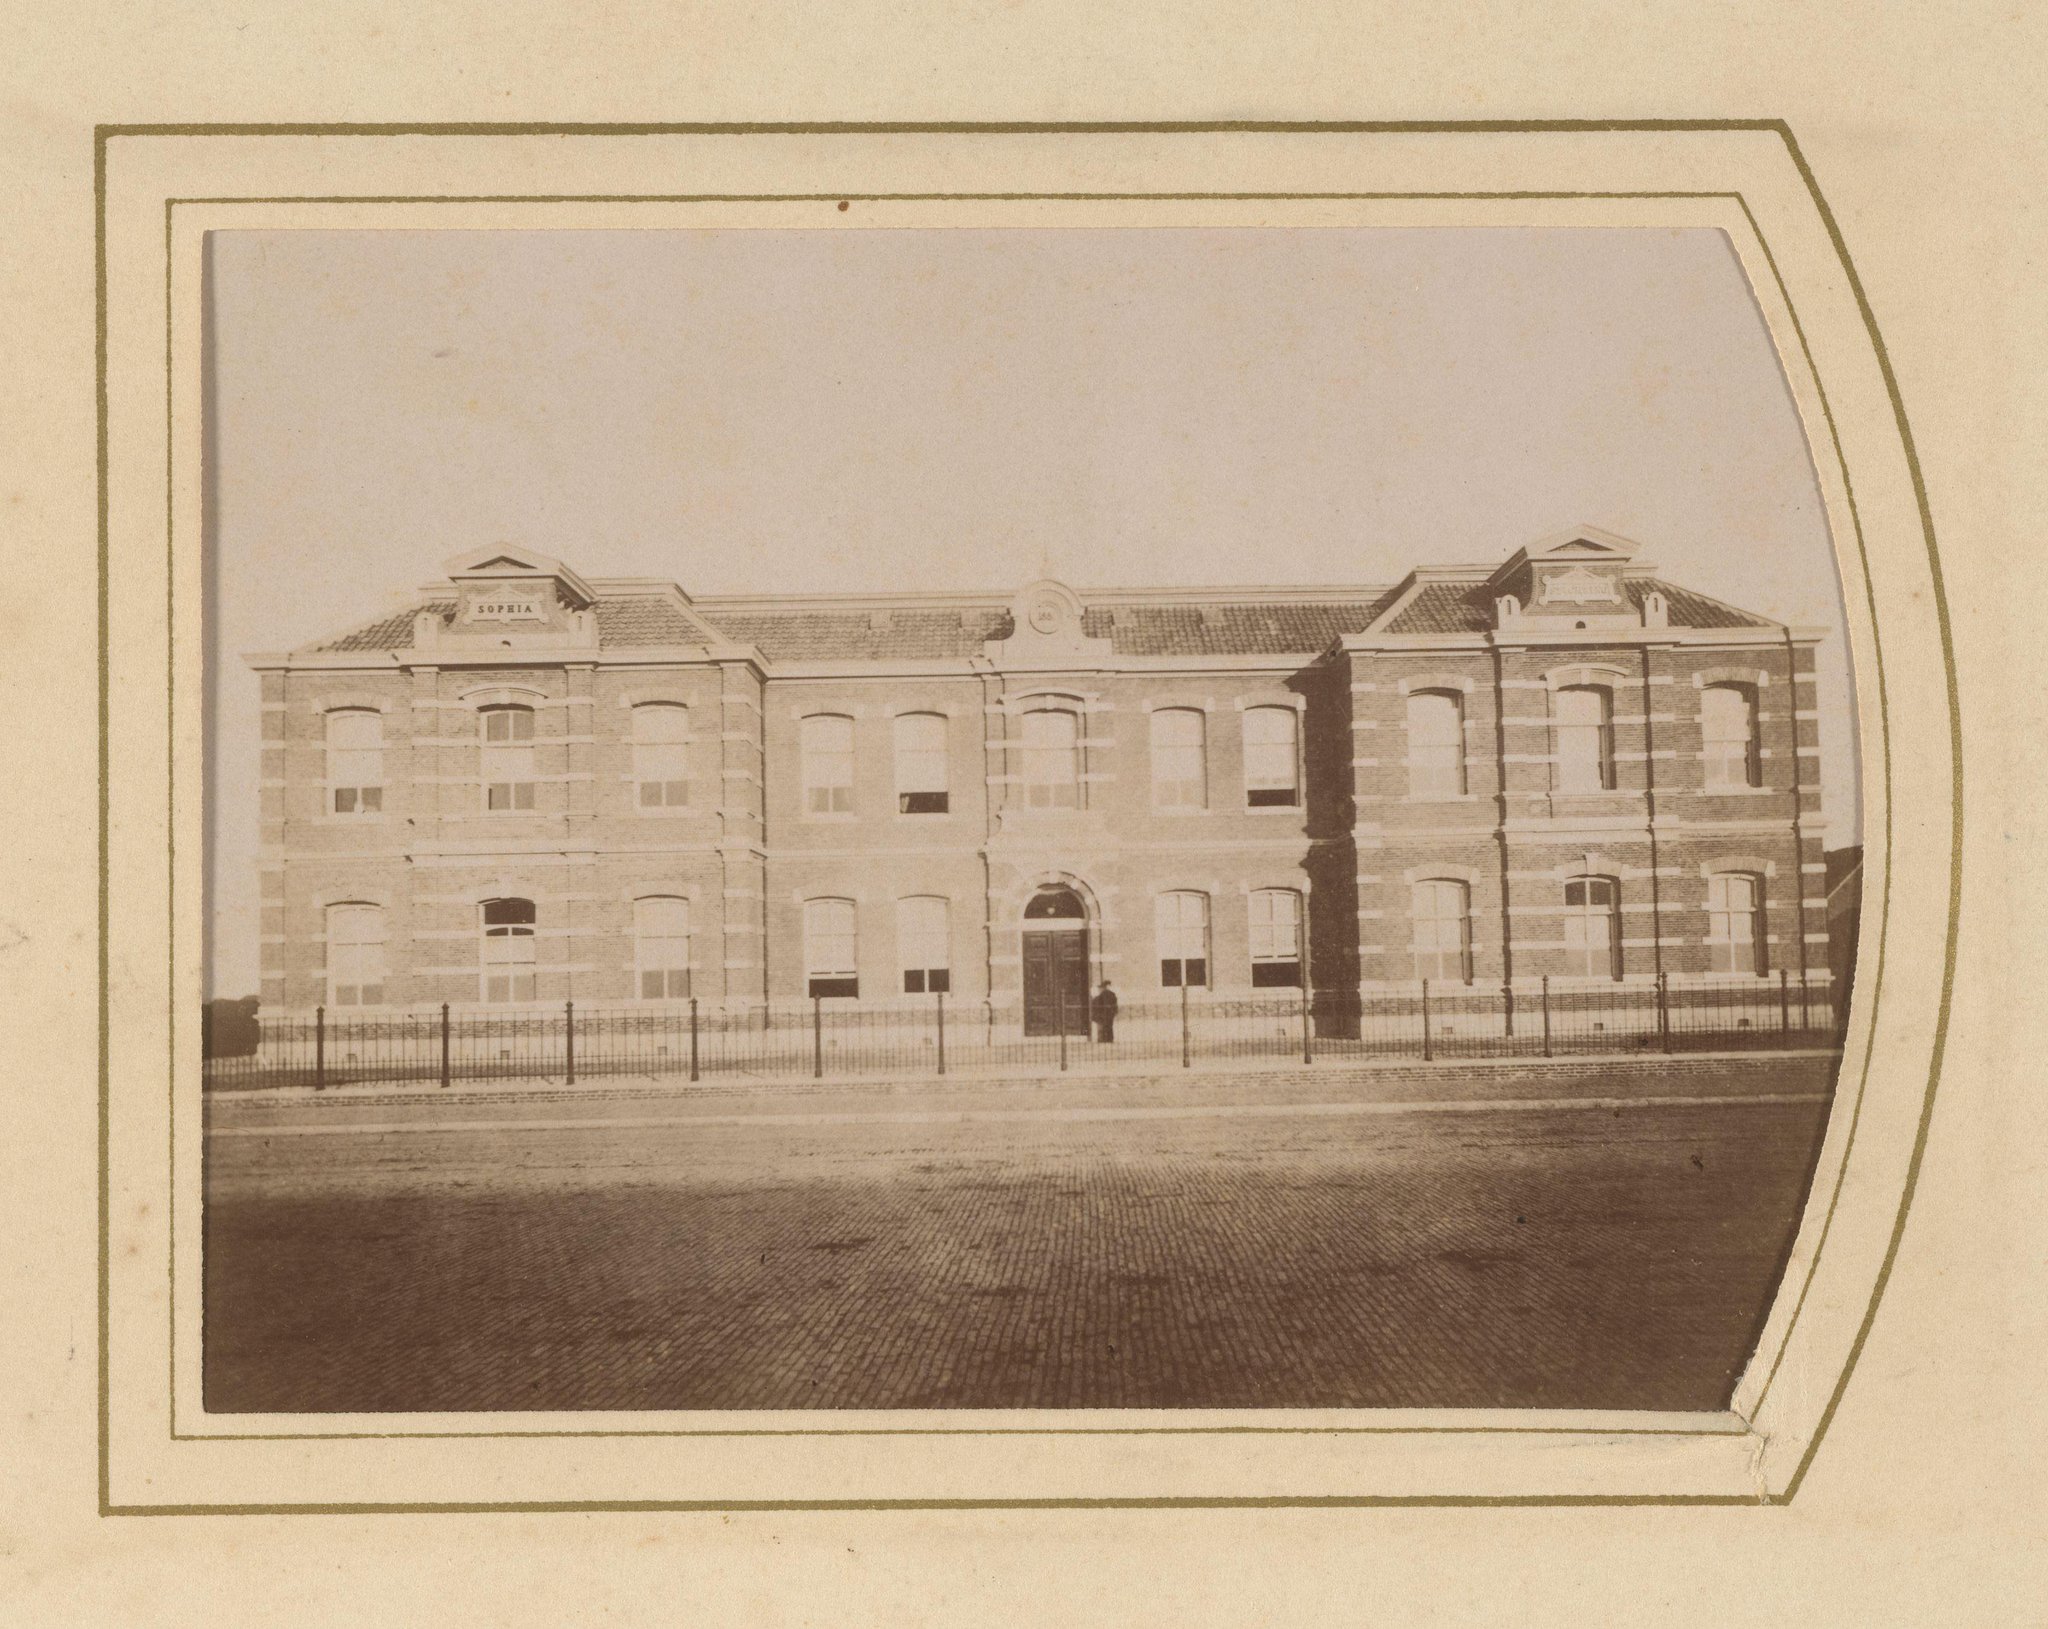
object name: photograph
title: Gezicht op het gebouw van de Sophia Stichting aan de Gevers Deynootweg in Den Haag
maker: heinrich wilhelm wollrabe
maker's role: fotograaf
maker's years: 1843-1928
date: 1877-1901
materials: cardboard, photographic support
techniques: albumen print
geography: the hague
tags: hospital, civic architecture; edifices; dwellings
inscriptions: inscription: ‘Photographie Instantanée/ H. W. Wollrabe/ HOFPHOTOGRAAF/ VAN H.H. M.M. DEN KONING EN DE KONINGIN,/ EN Z.K.H. PRINS ALEXANDER DER NEDERLANDEN/ PRINS VAN ORANJE/ 96. Noordeinde 96/ 's Gravenhage/ Portretten tot in levensgrootte./ Photographien van Gebouwen en Schilderijen./ Onvergankelijke vergrootingen naar elk portret./ Voor nabestelling wordt de origineele plaat bewaard.’